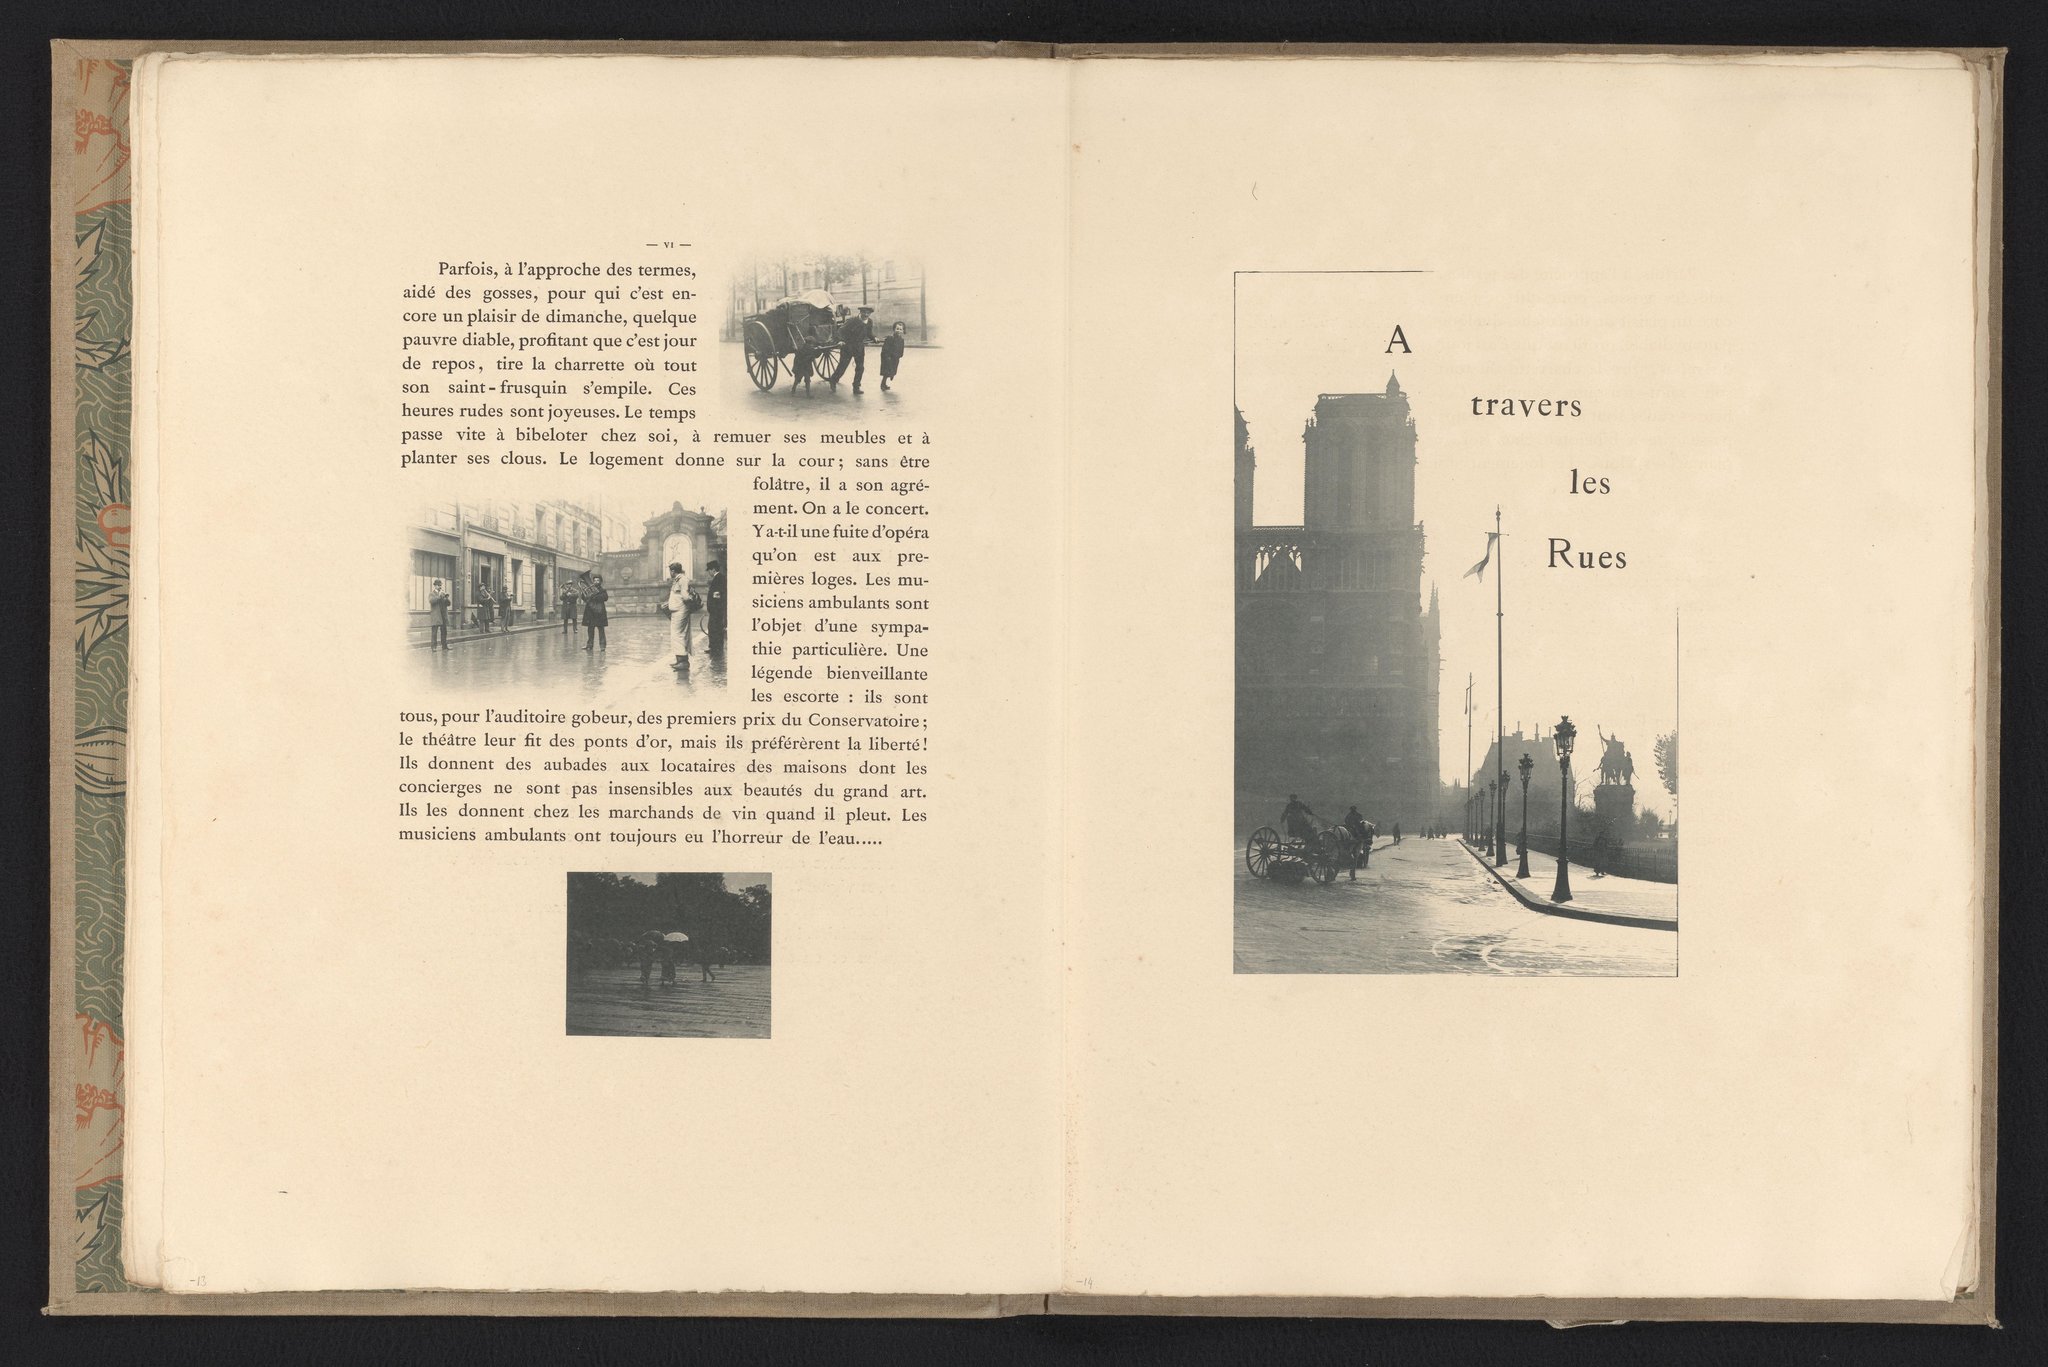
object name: album leaf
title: Á travers les rues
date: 1896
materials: paper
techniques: photograph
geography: châteaudun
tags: church (exterior)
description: Prent op eenentwintigste ongenummerde pagina.